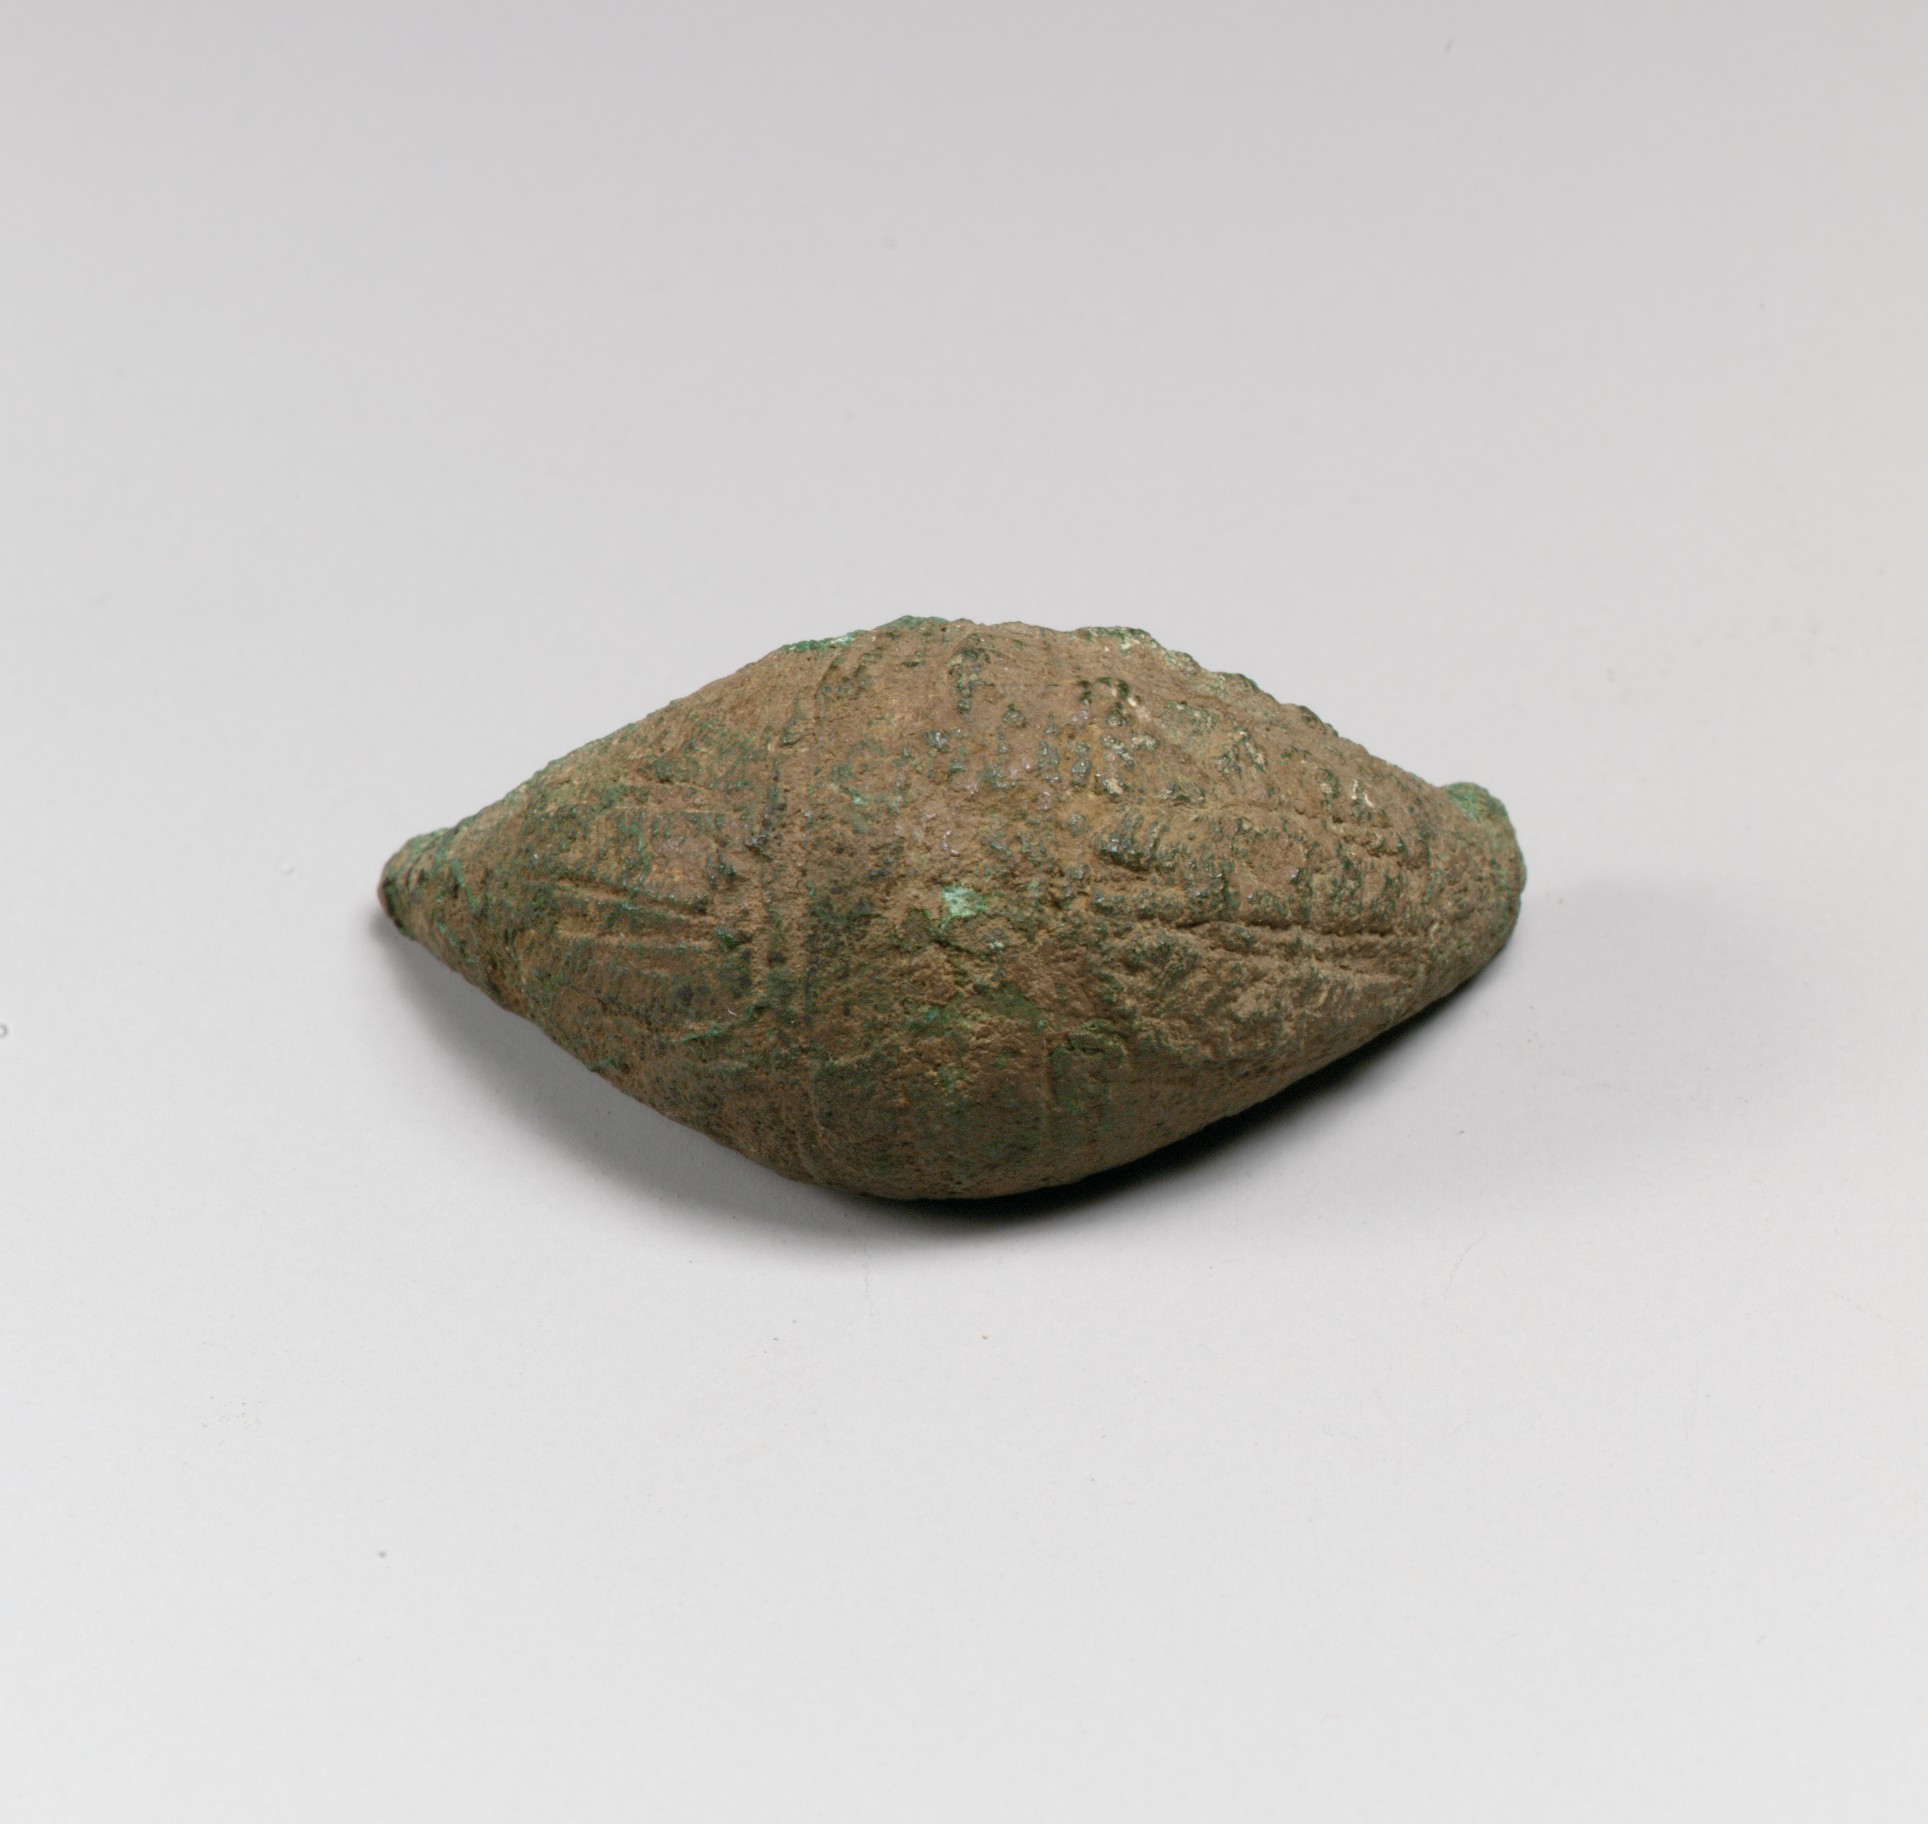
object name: fibula, boat shaped type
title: Fibula, boat-shaped type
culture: italic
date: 800-501 BCE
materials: bronze